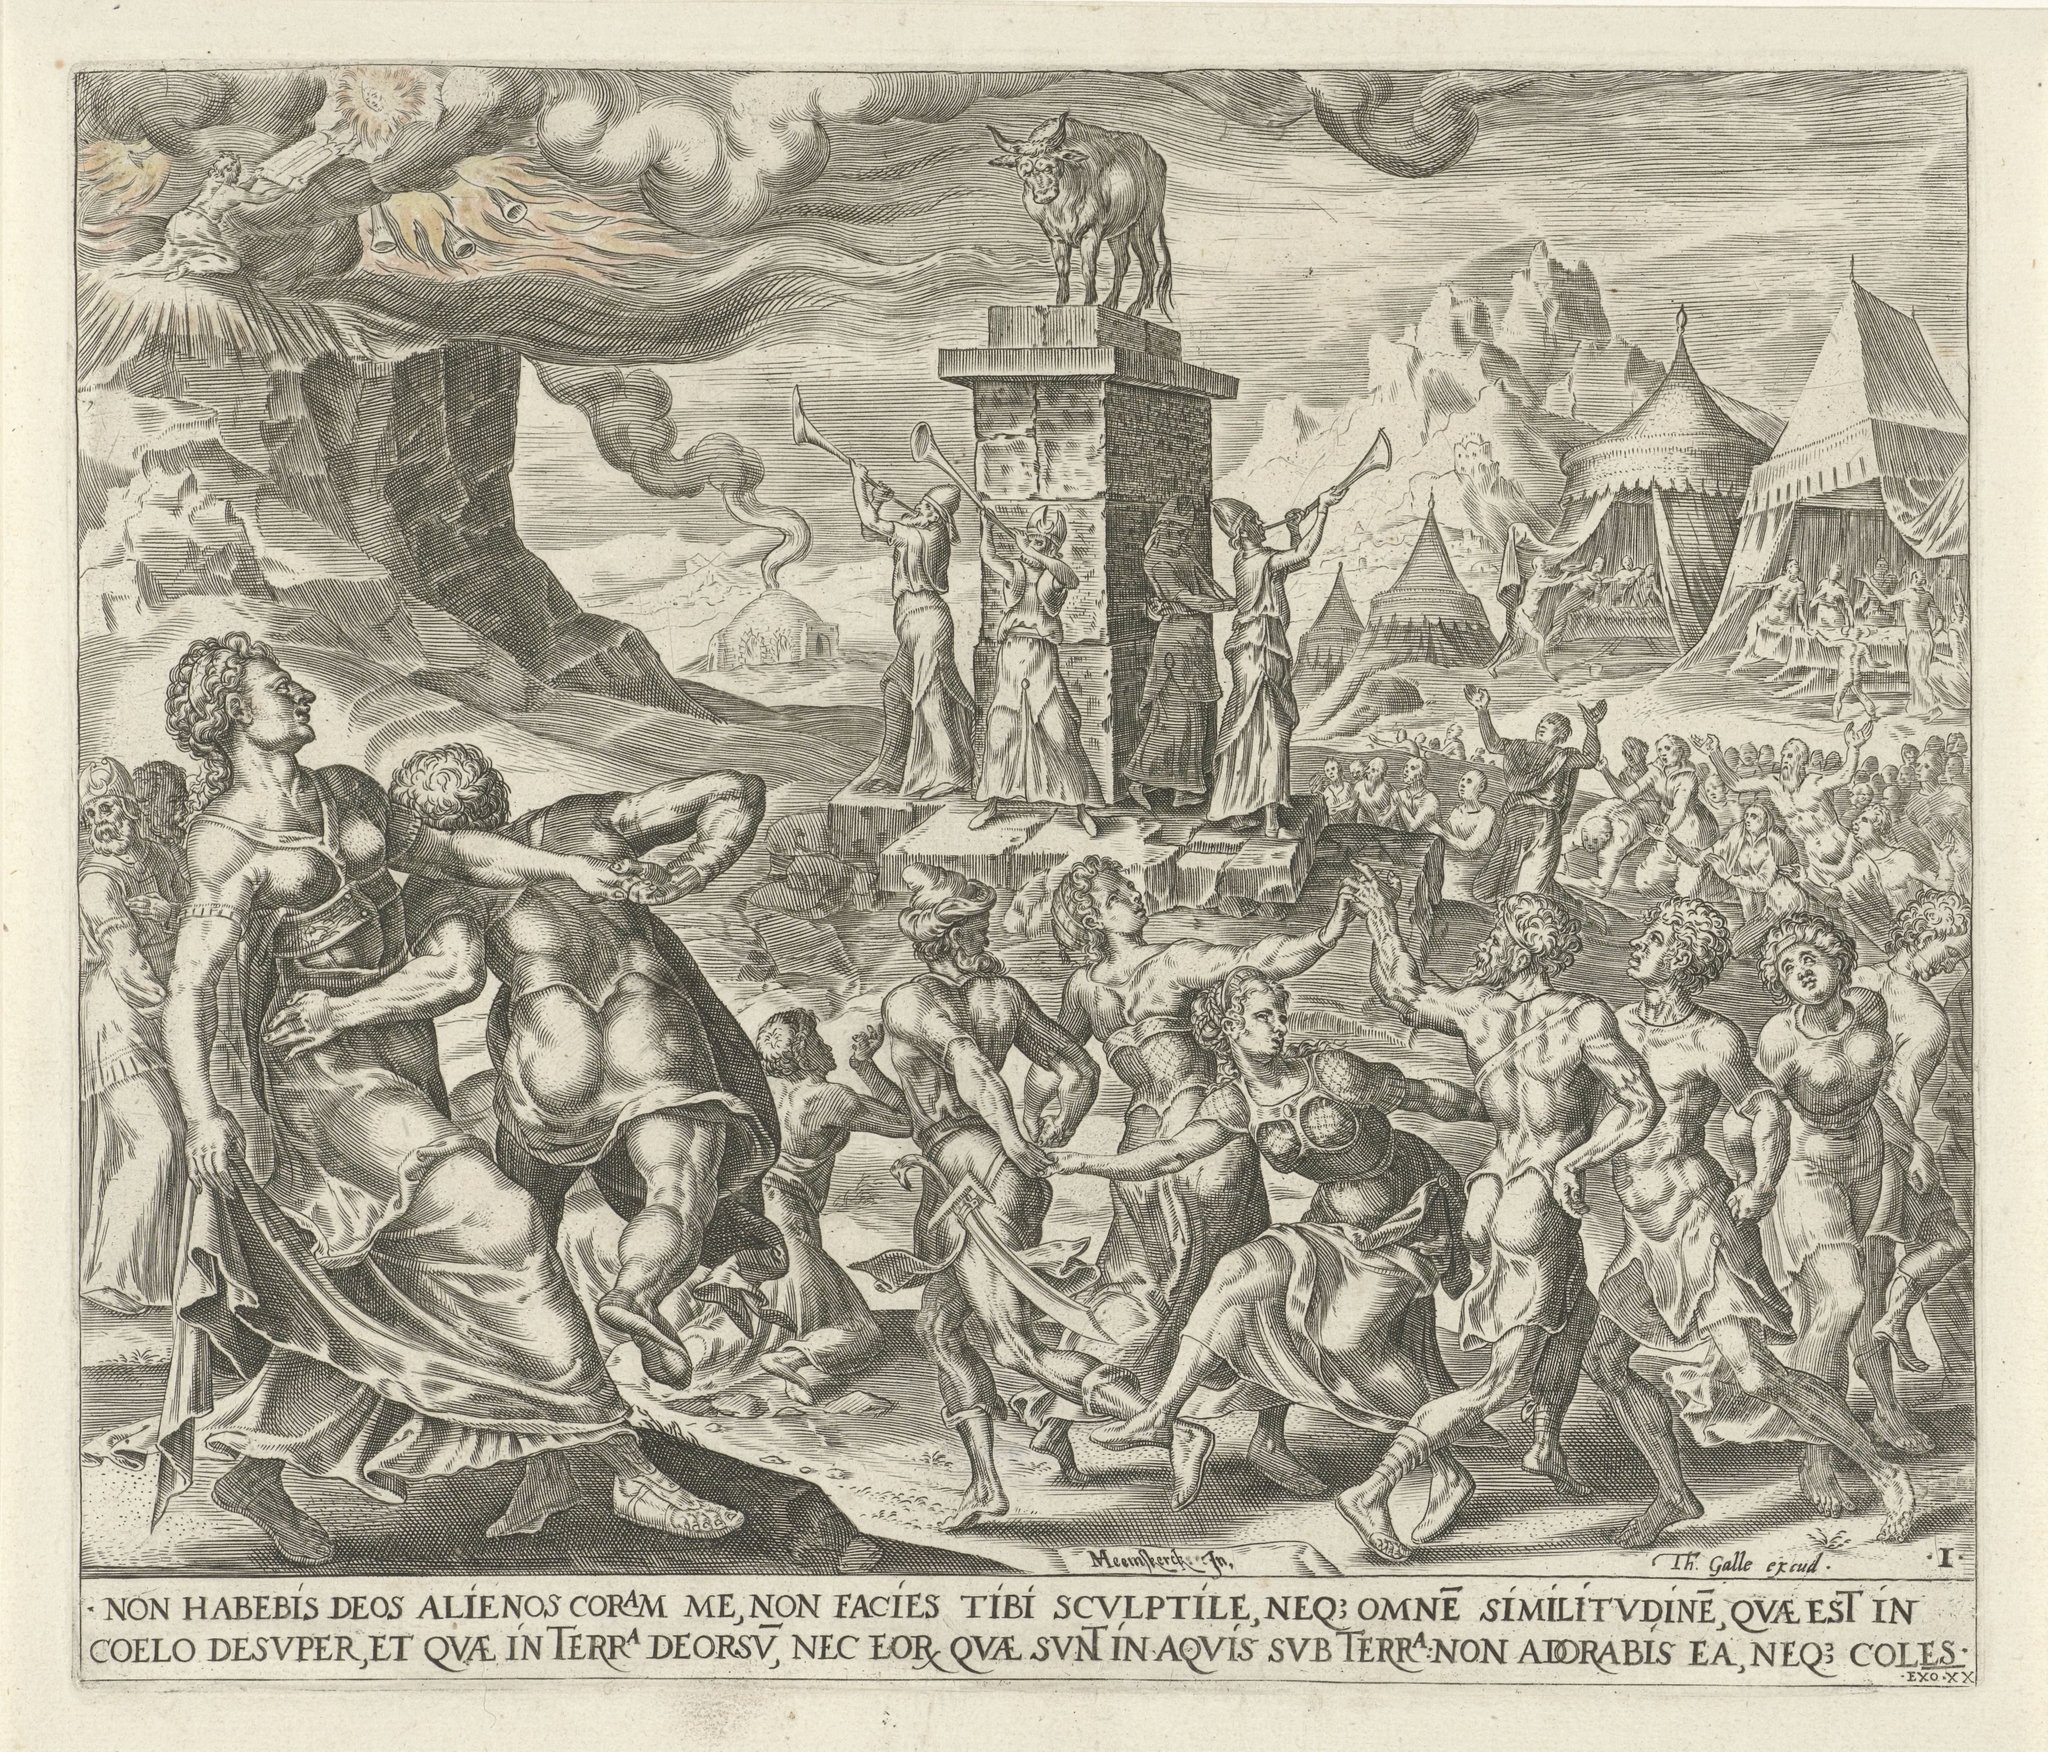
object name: print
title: Israëlieten dansen rond het gouden kalf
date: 1596-1633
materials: paper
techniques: engraving, hand coloring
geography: amsterdam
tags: 'you shall have no other gods' ~ separate representation of the first of the ten commandments, the people dance around the golden calf ~ exodus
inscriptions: collector's mark: Lugt 2228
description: De Israëlieten dansen rond het gouden kalf, terwijl Mozes op de berg de tien geboden van God ontvangt. Prent maakt deel uit van een serie over de tien geboden en geeft een overtreding van het eerste gebod weer: Gij zult geen andere goden voor mijn aangezicht hebben. Onderaan in de marge een verwijzing naar de Bijbeltekst in het Latijn.